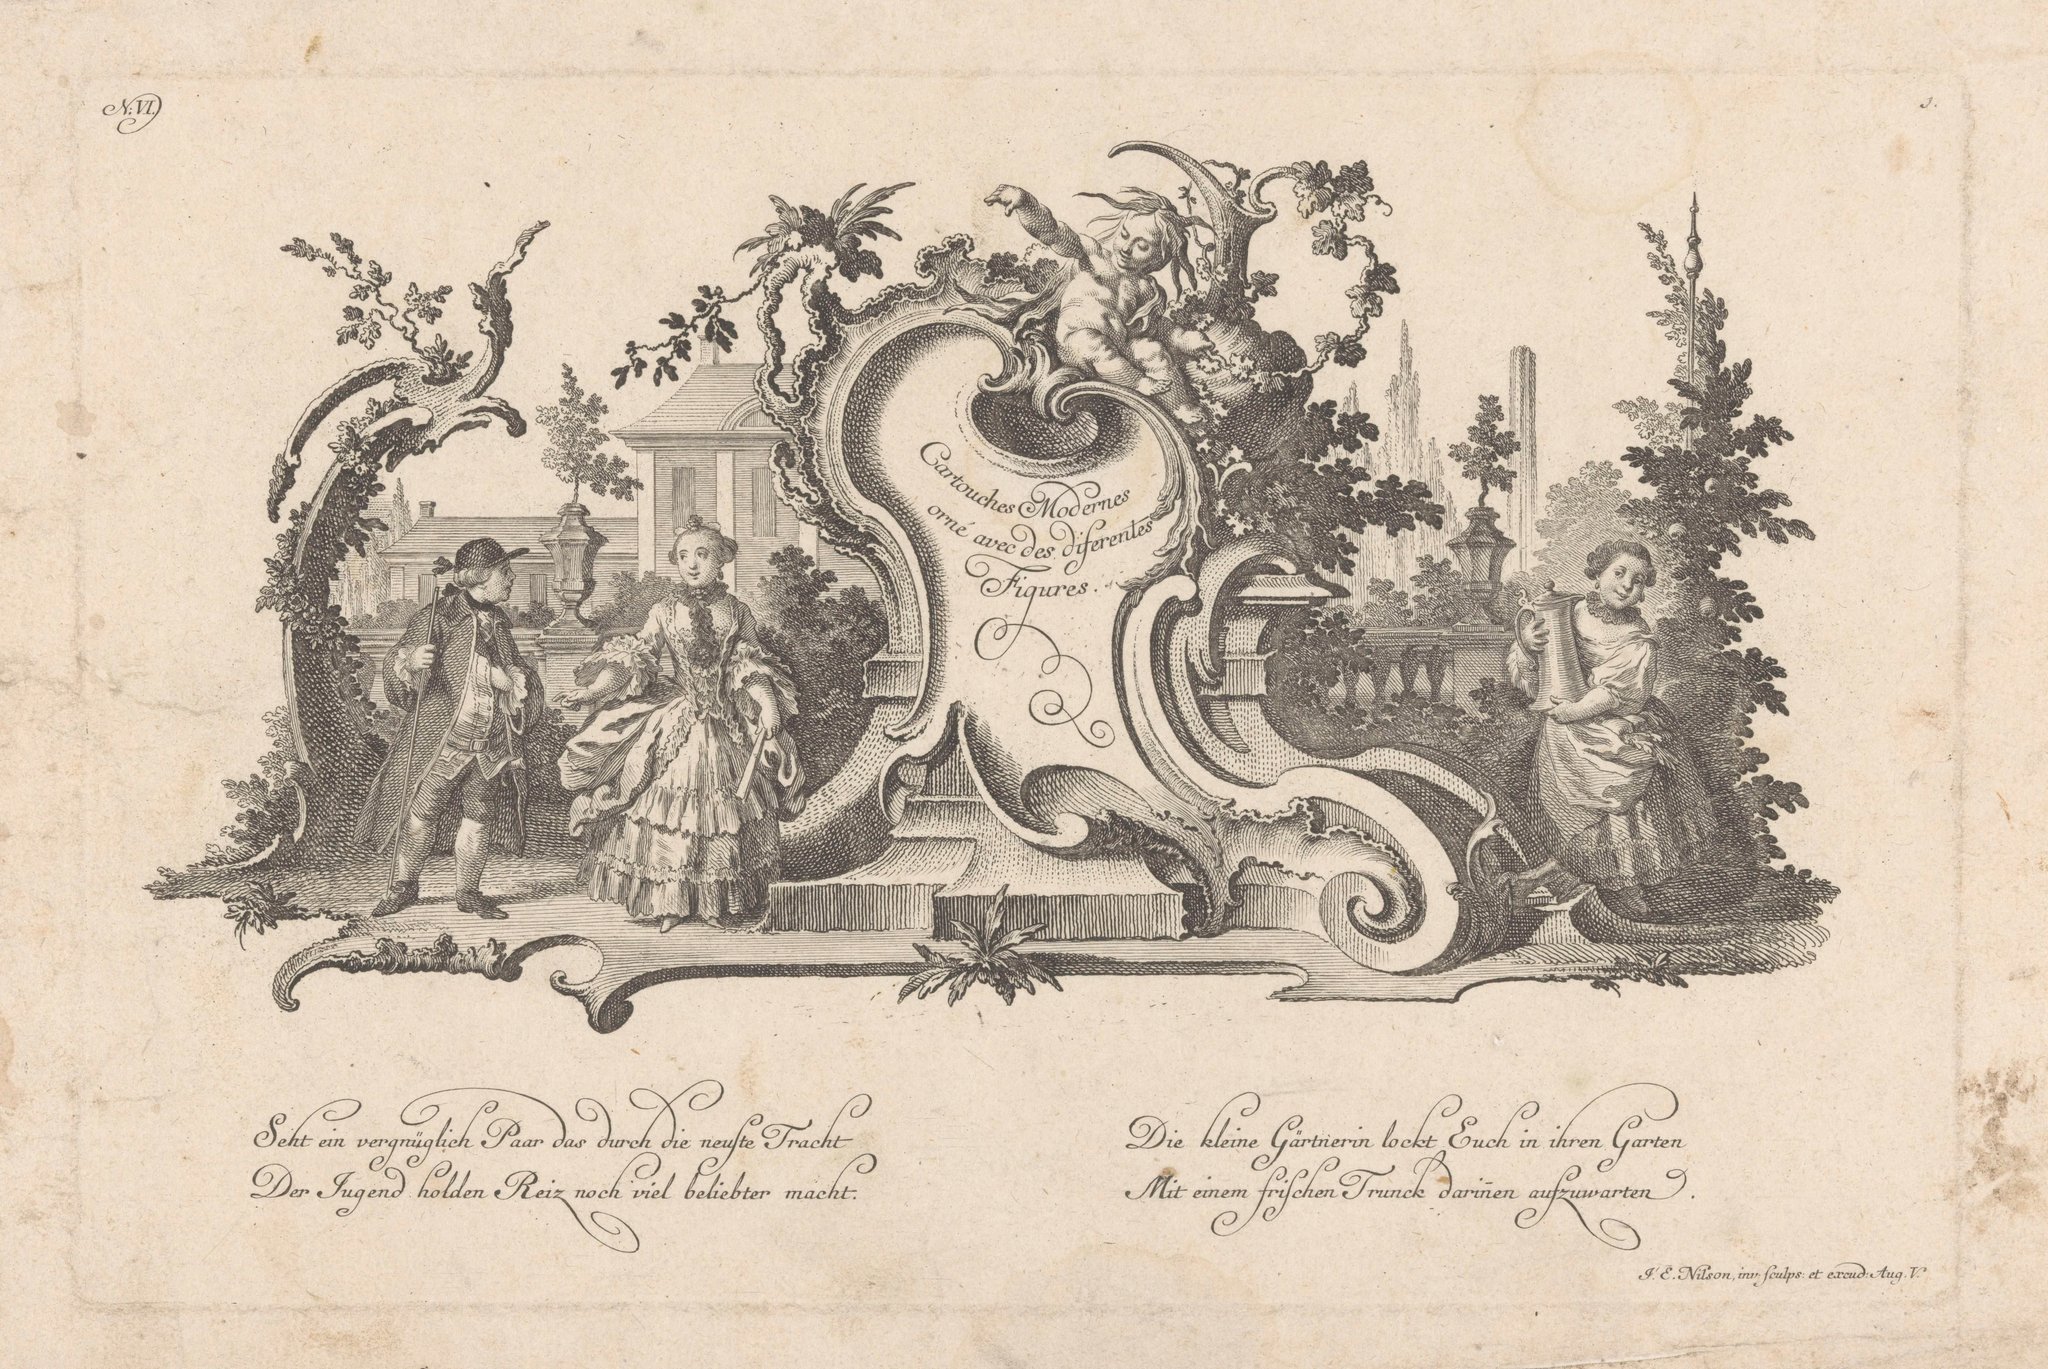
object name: titelprent, frontispice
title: Cartouches Modernes orné avec des diferentes Figures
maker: johann esaias nilson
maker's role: draughtsman, print maker, publisher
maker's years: 1721-1788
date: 1731-1788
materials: paper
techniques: engraving, etching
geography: augsburg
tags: the (nude) human figure; 'corpo humano' (ripa) (+ three persons), ornament ~ cartouche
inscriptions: collector's mark: Lugt 2228, collector's mark: Lugt 2760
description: Een putto zit naast een vaas op een rocaille cartouche met de serietitel. Links van de cartouche staan een man en vrouw, rechts staat een vrouw met een kan. In de ondermarge twee kolommen met tweeregelige Duitse tekst. Uitgeversnummer VI.